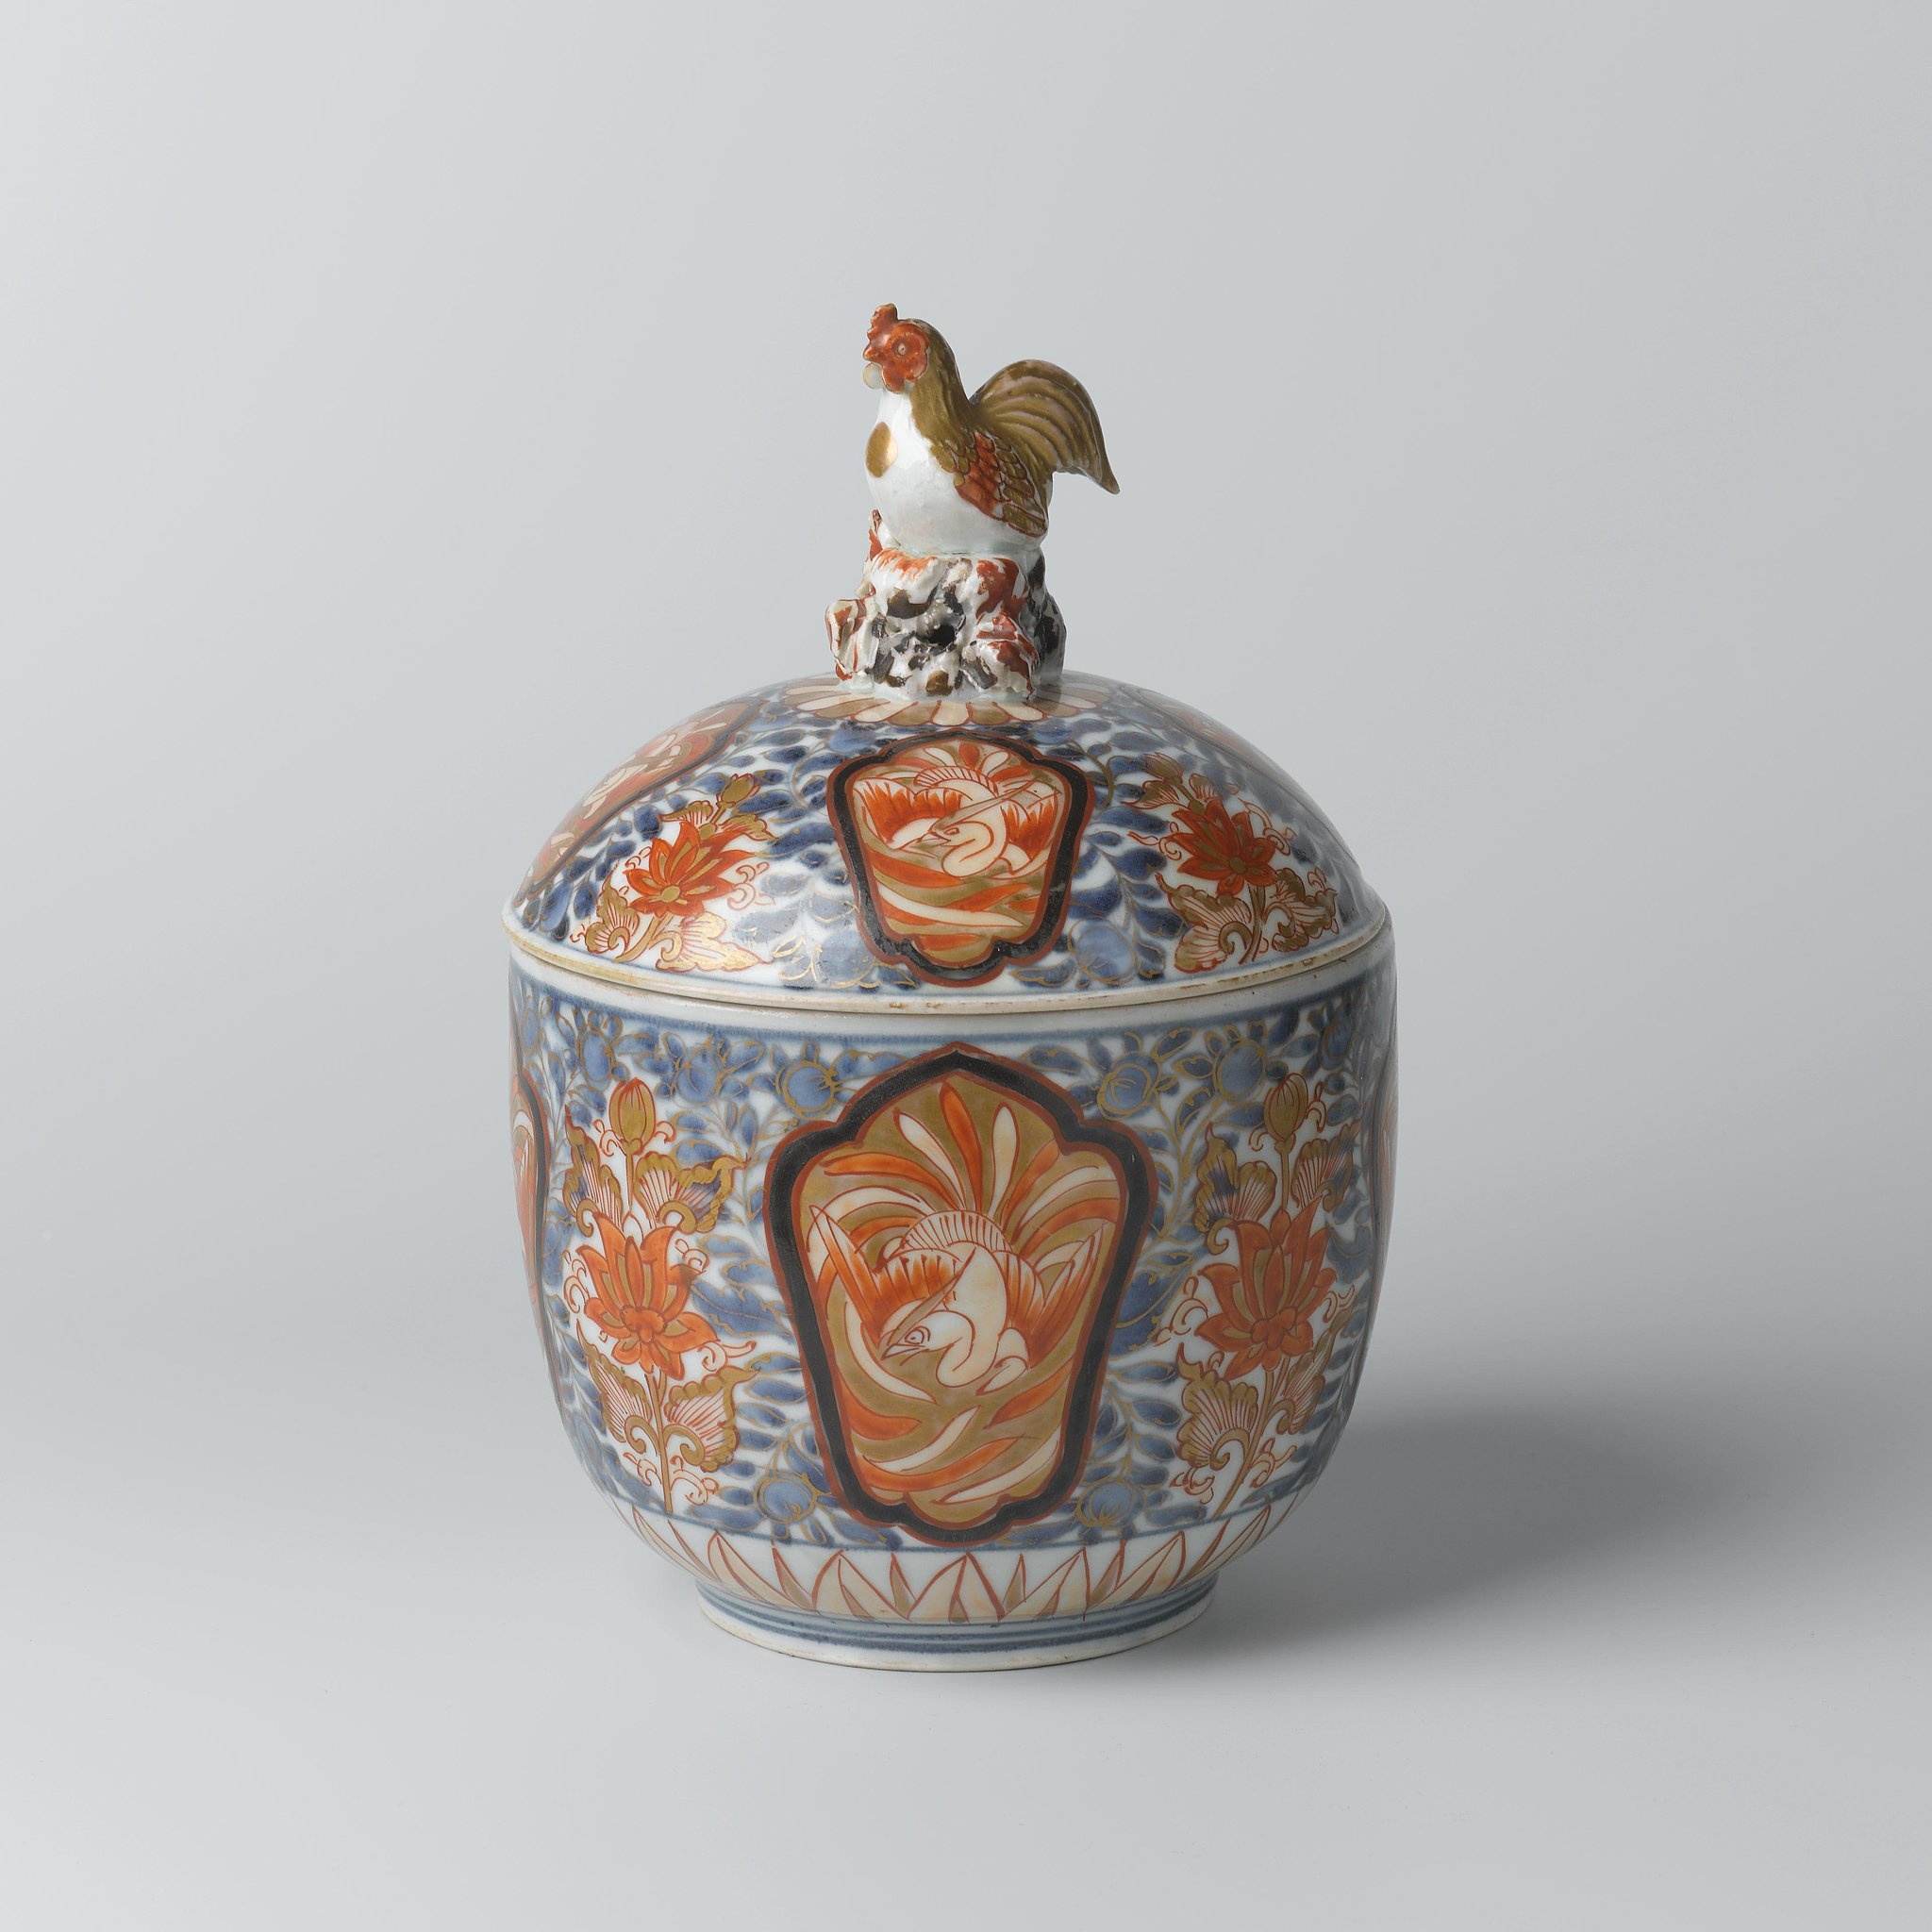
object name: covered jar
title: Covered jar with hoo-birds in panels on a ground of lotus and floral scrolls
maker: Anonymous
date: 1720-1770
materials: cobalt, glaze, gold, paint, porcelain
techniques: firing, gilding, turning, vitrification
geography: japan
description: Dekselpot van porselein, beschilderd in onderglazuur blauw en op het glazuur rood, zwart en goud. Op de buitenwand bloemranken met hierin uitgespaard afwisselend een lotusrank en een cartouche met een hoo-vogel. Rond de voet een band met puntige bladmotieven. Imari.